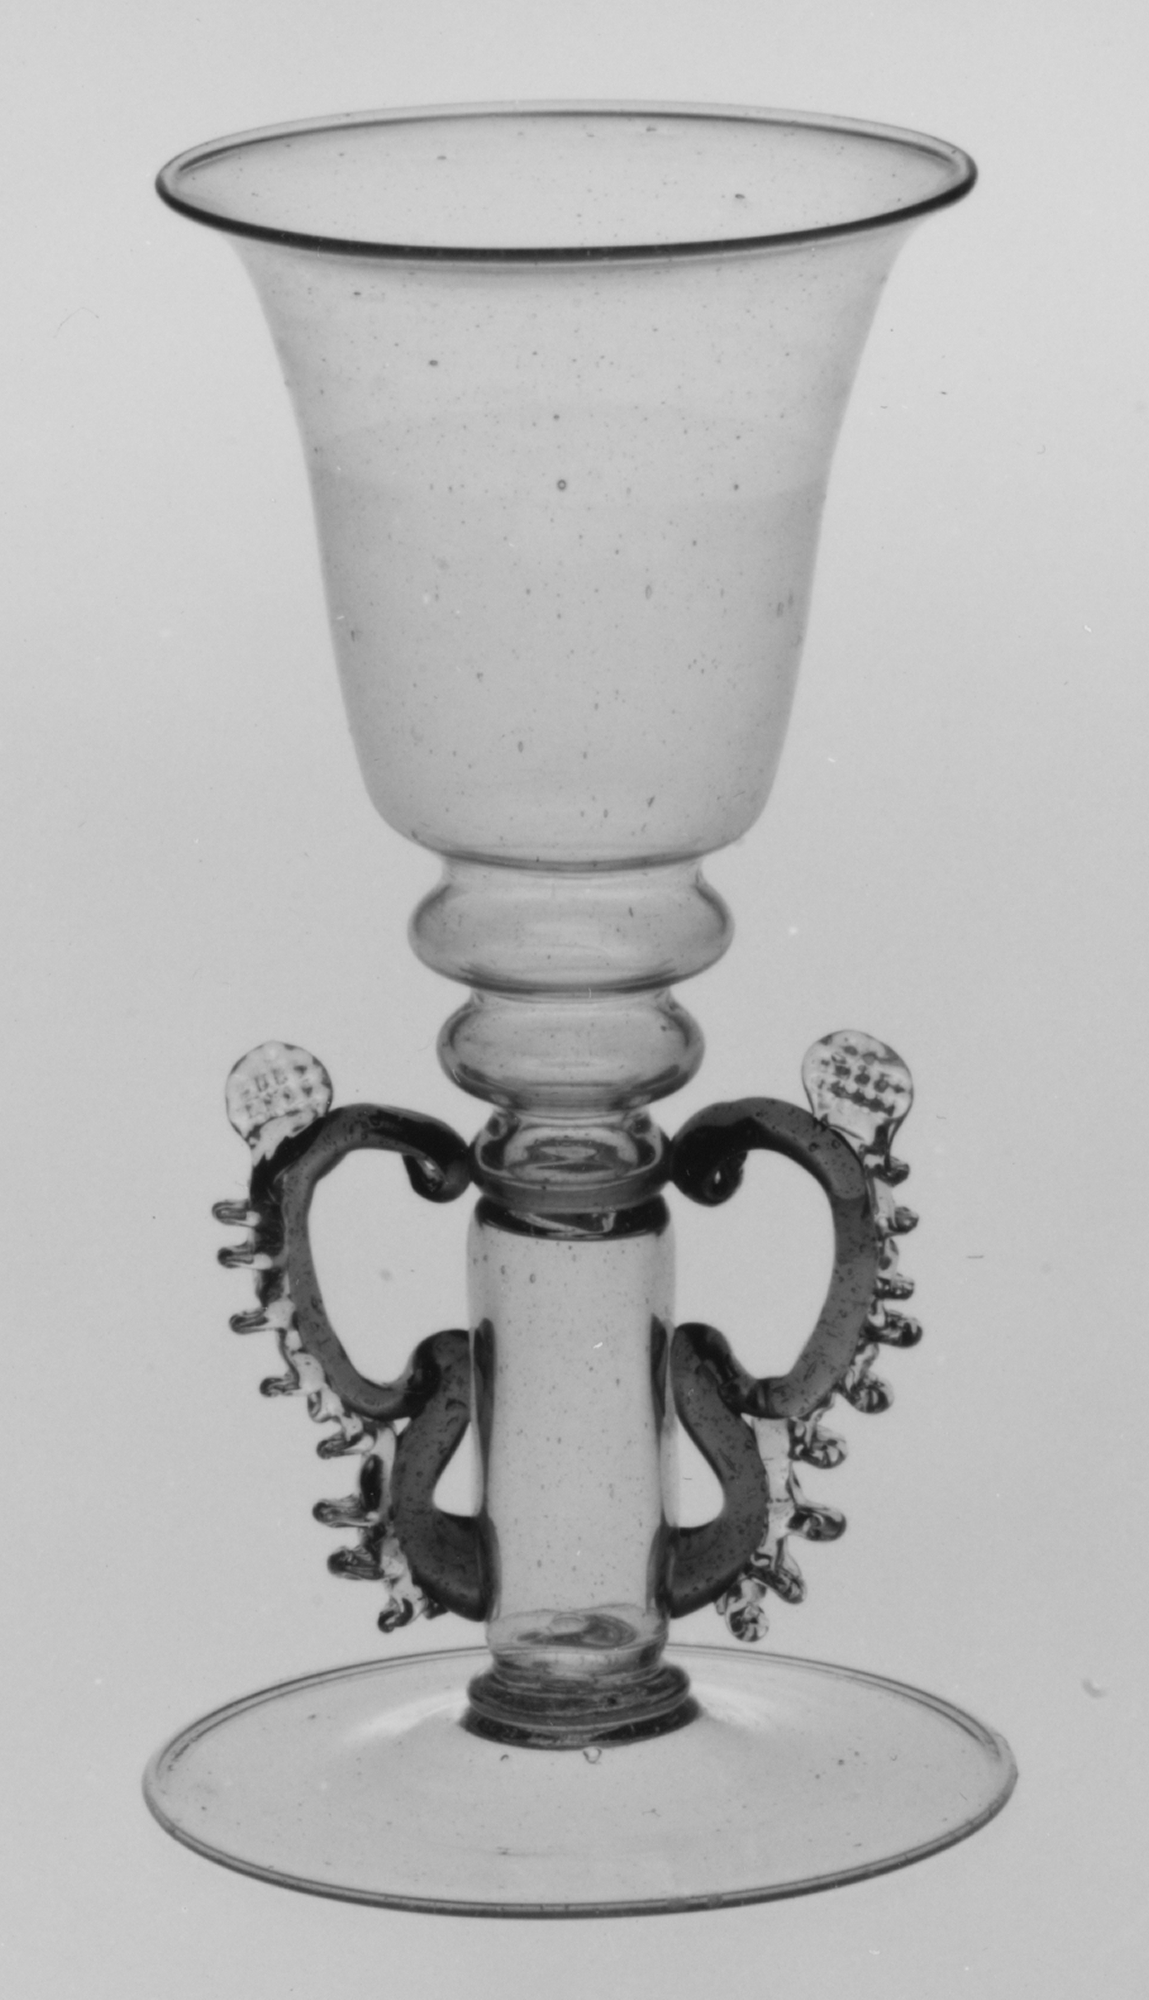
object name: wineglass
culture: façon de venise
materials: glass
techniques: glassblowing